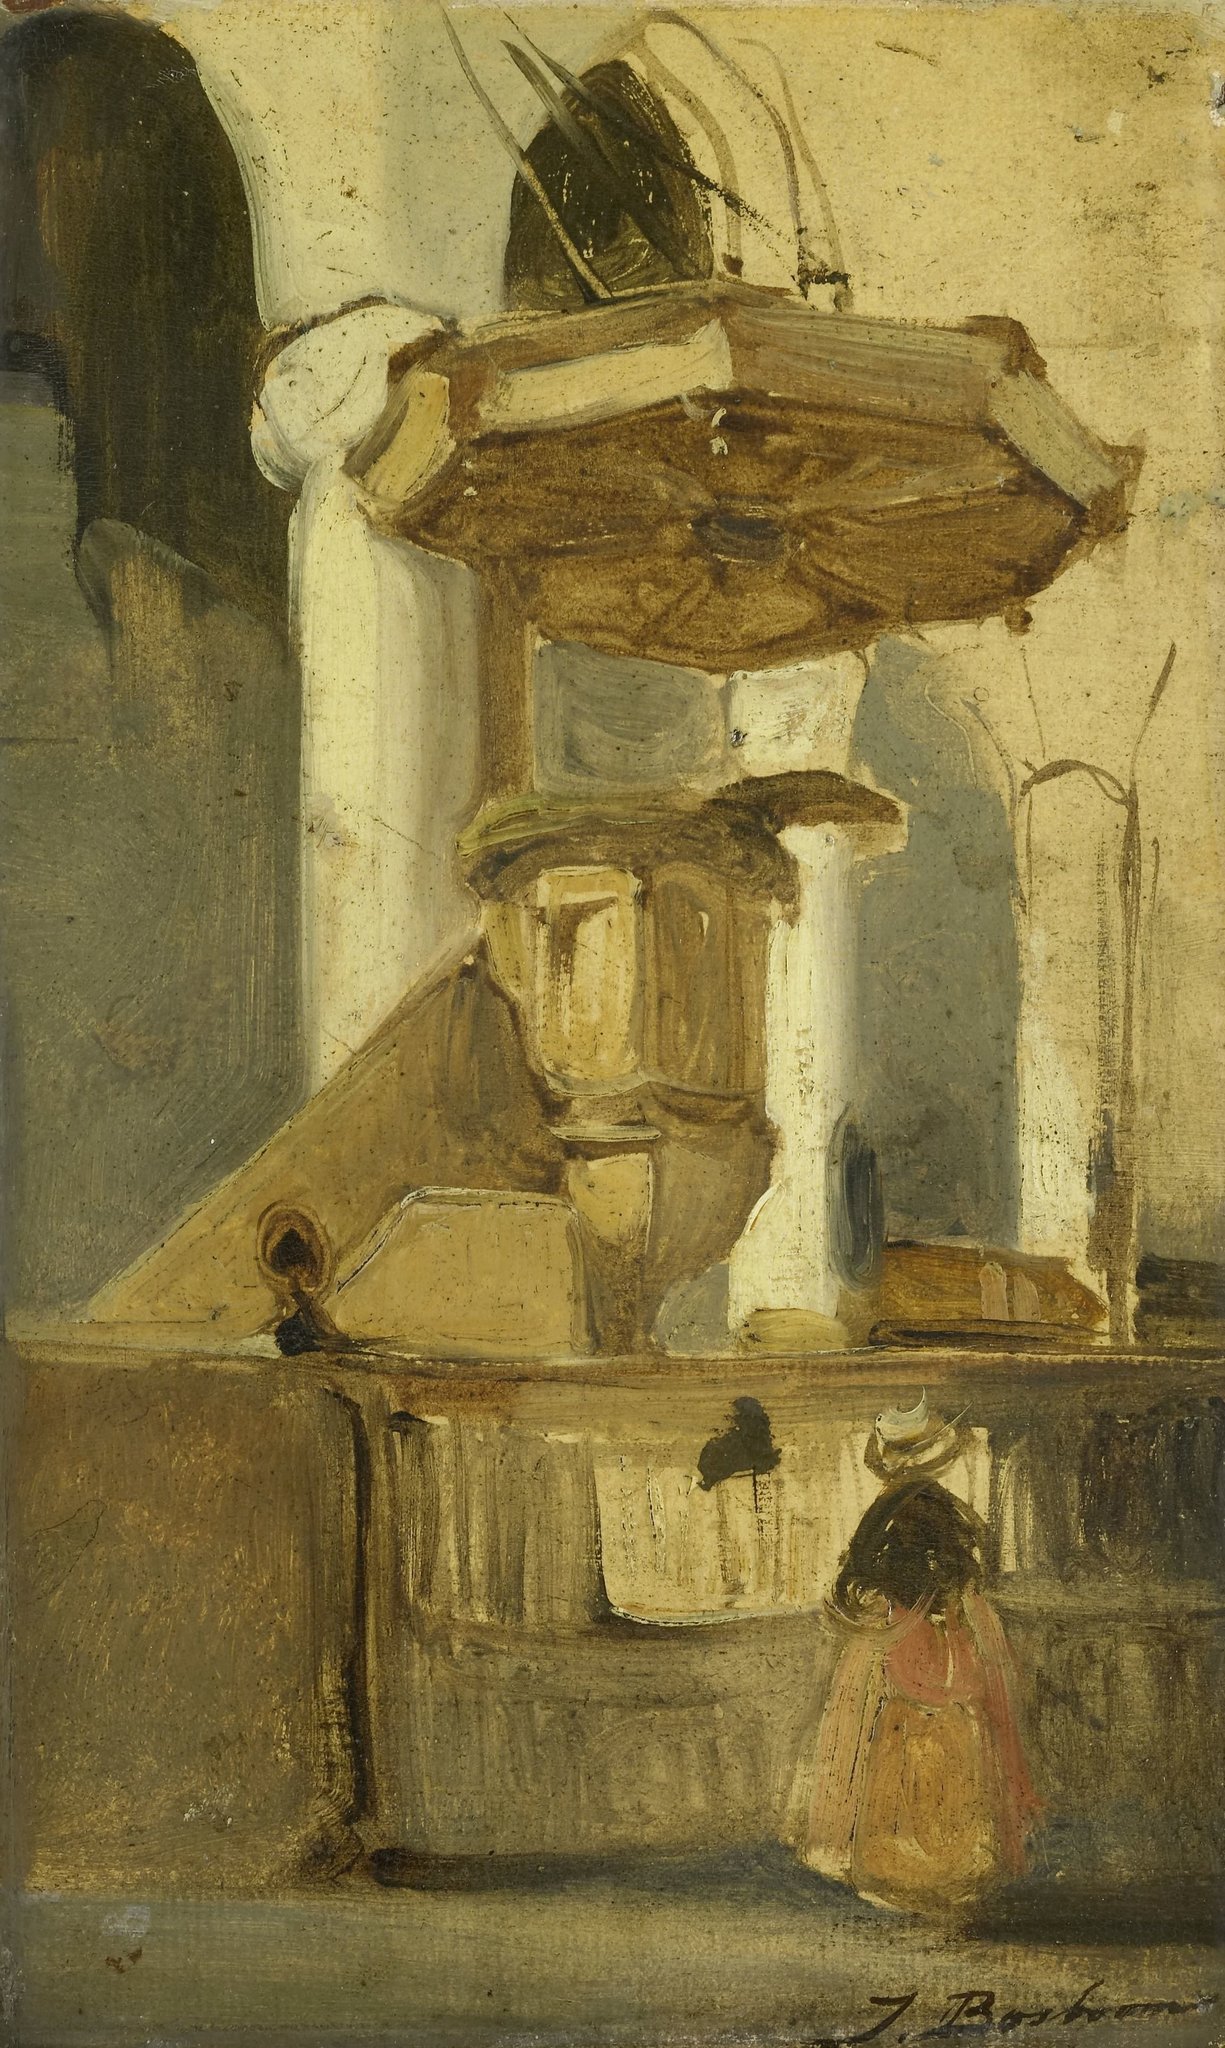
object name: painting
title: The Pulpit of the Church in Hoorn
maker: johannes bosboom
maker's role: draughtsman, painter, print maker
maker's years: 1817-1891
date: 1860-1891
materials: oil, panel, paper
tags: interior of church, pulpit, ambo, chancel, hoorn (north holland)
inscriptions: signature: ‘J. Bosboom’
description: Interieur van een kerk te Hoorn met de preekstoel. Op de voorgrond een staande vrouw.